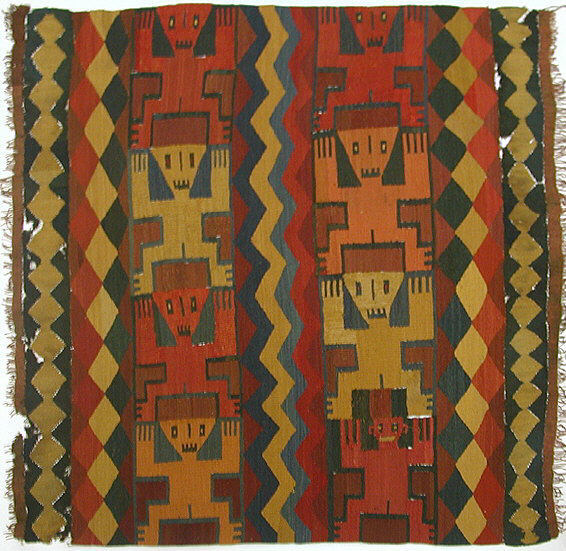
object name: panel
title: Panel with figures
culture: south highlands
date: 601-1000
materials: animal fiber, cotton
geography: peru